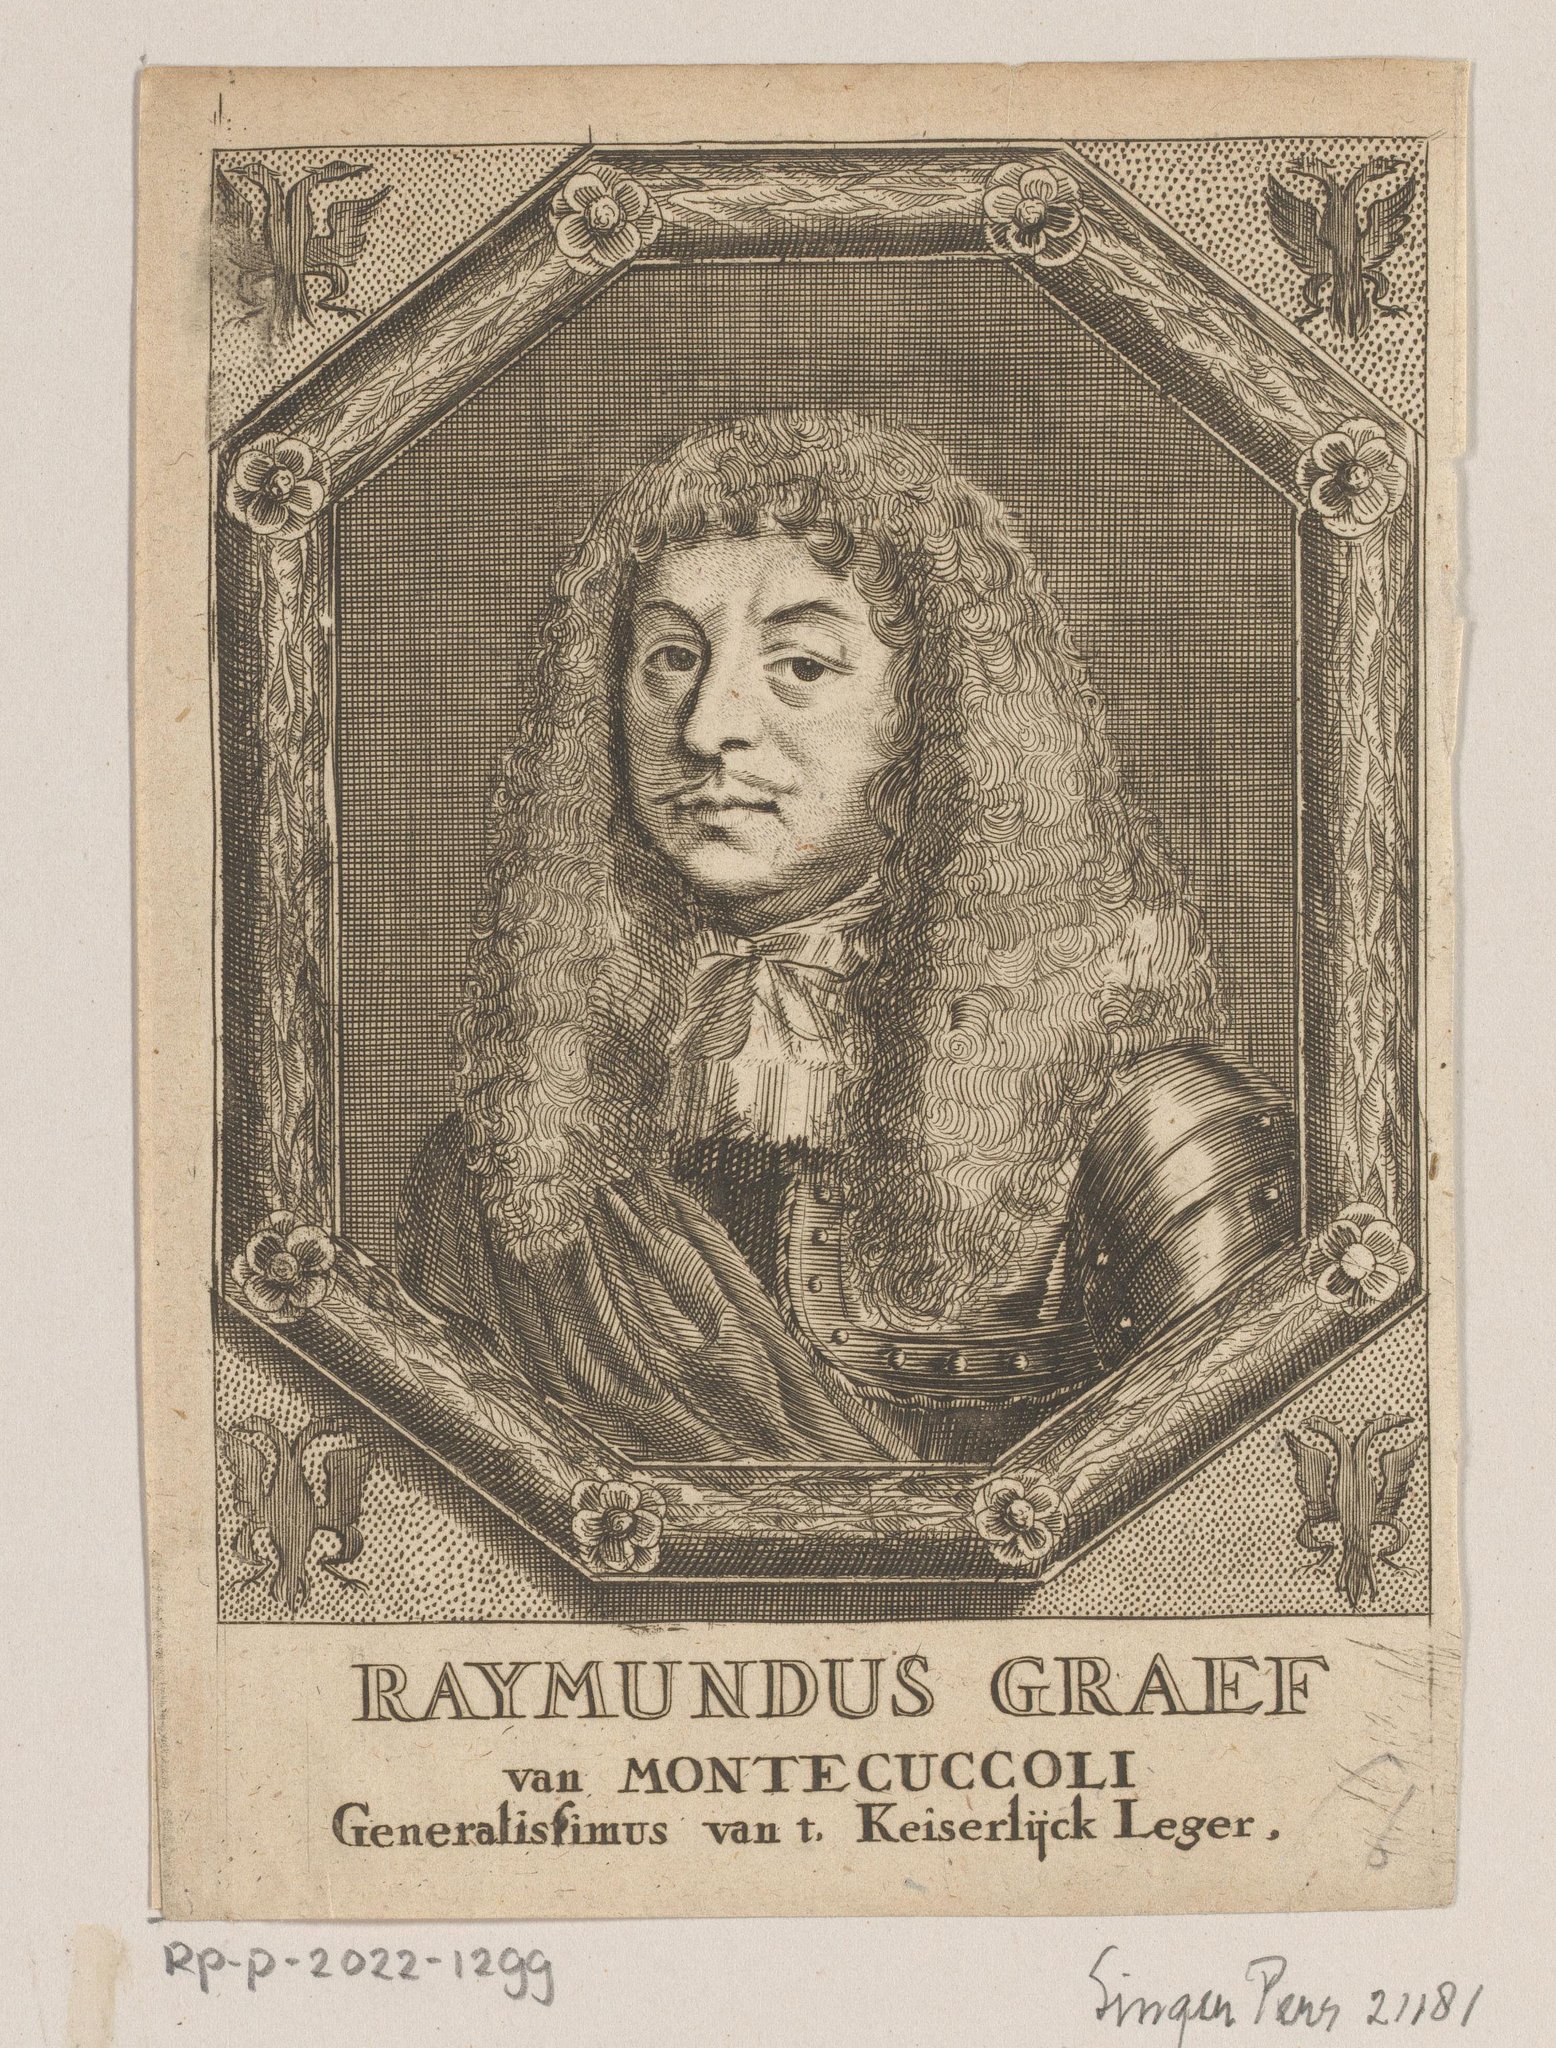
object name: print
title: Portret van Raimondo Montecuccoli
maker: Anonymous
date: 1642-1750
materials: paper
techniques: engraving, etching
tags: commander-in-chief, general, marshal, historical persons